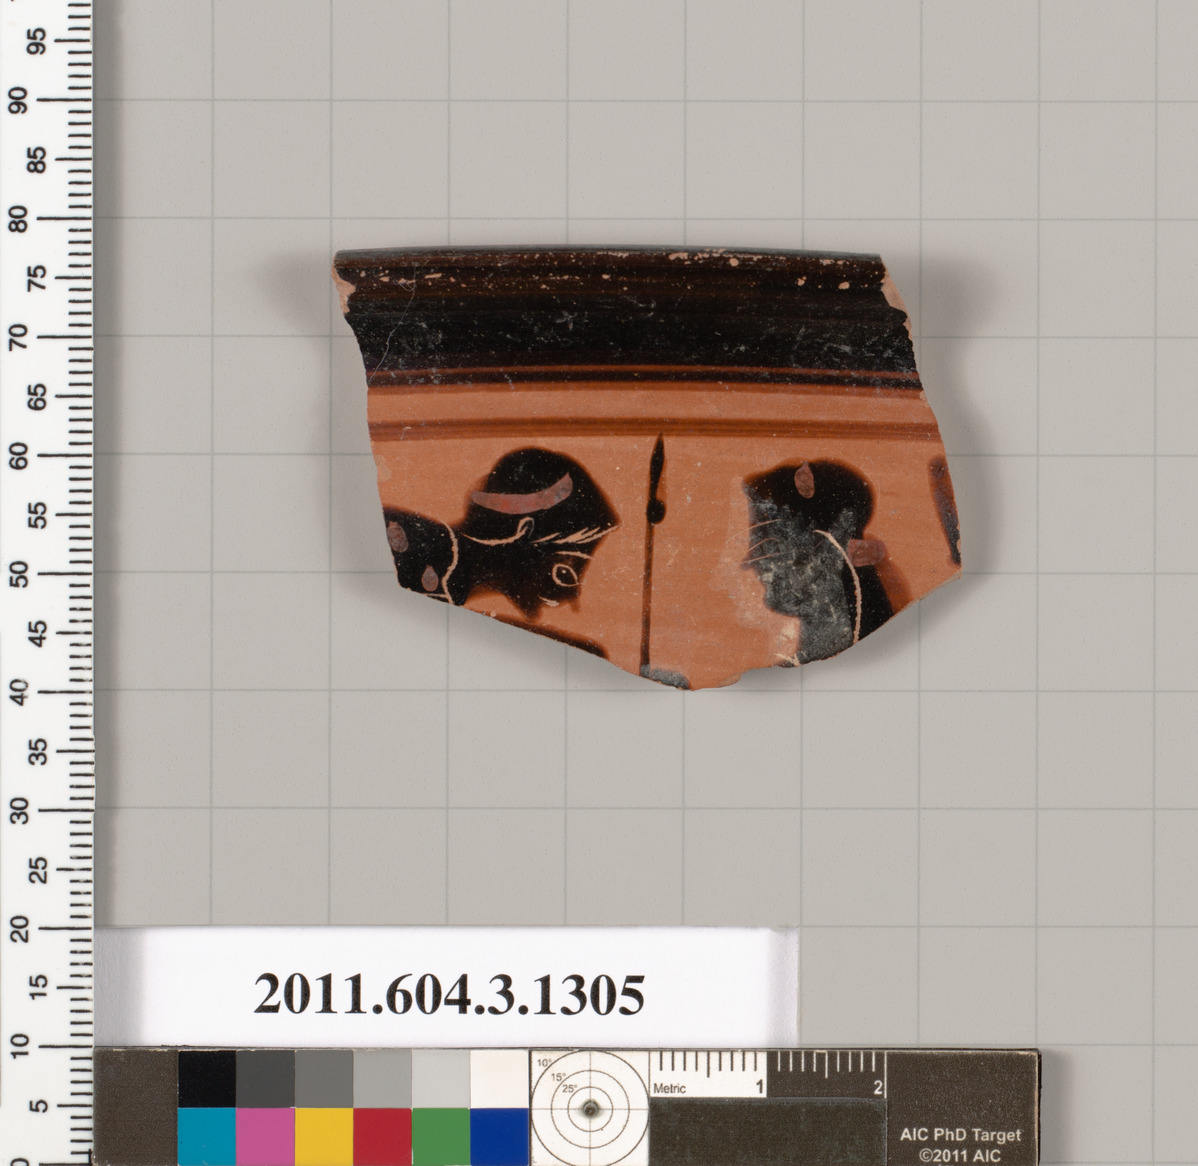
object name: skyphos fragment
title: Terracotta rim fragment of a skyphos (deep drinking cup)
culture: greek, attic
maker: painter of the nicosia olpe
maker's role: artist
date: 567-535 BCE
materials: terracotta